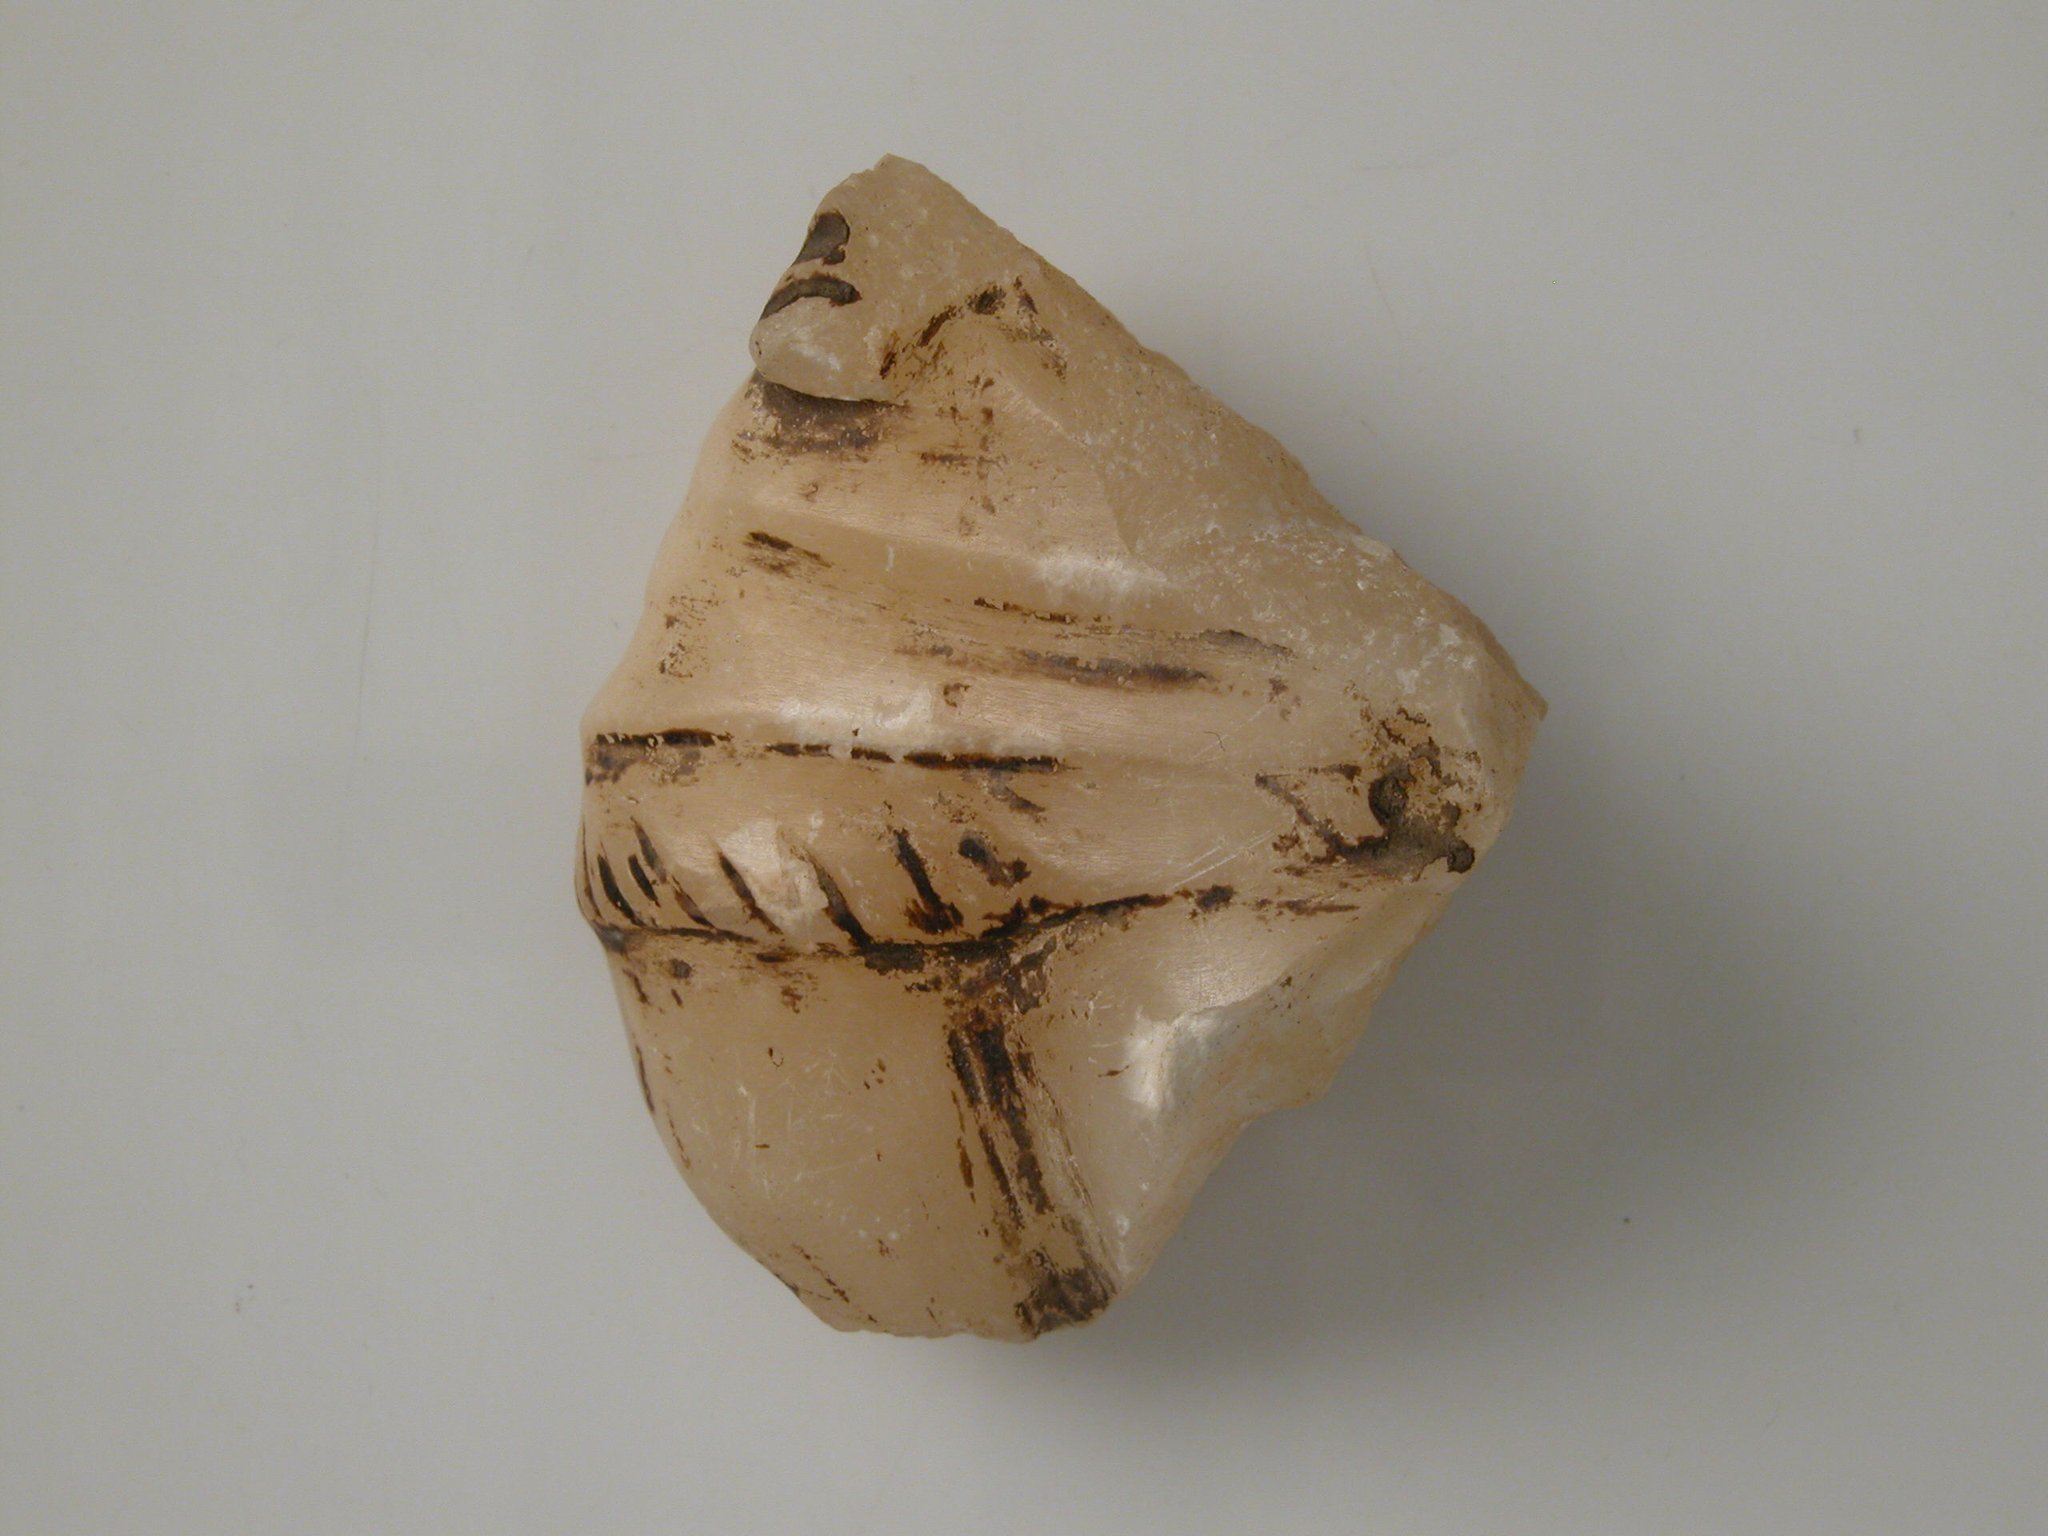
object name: statuette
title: Fragment of a Figure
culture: coptic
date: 301-700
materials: stone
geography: egypt